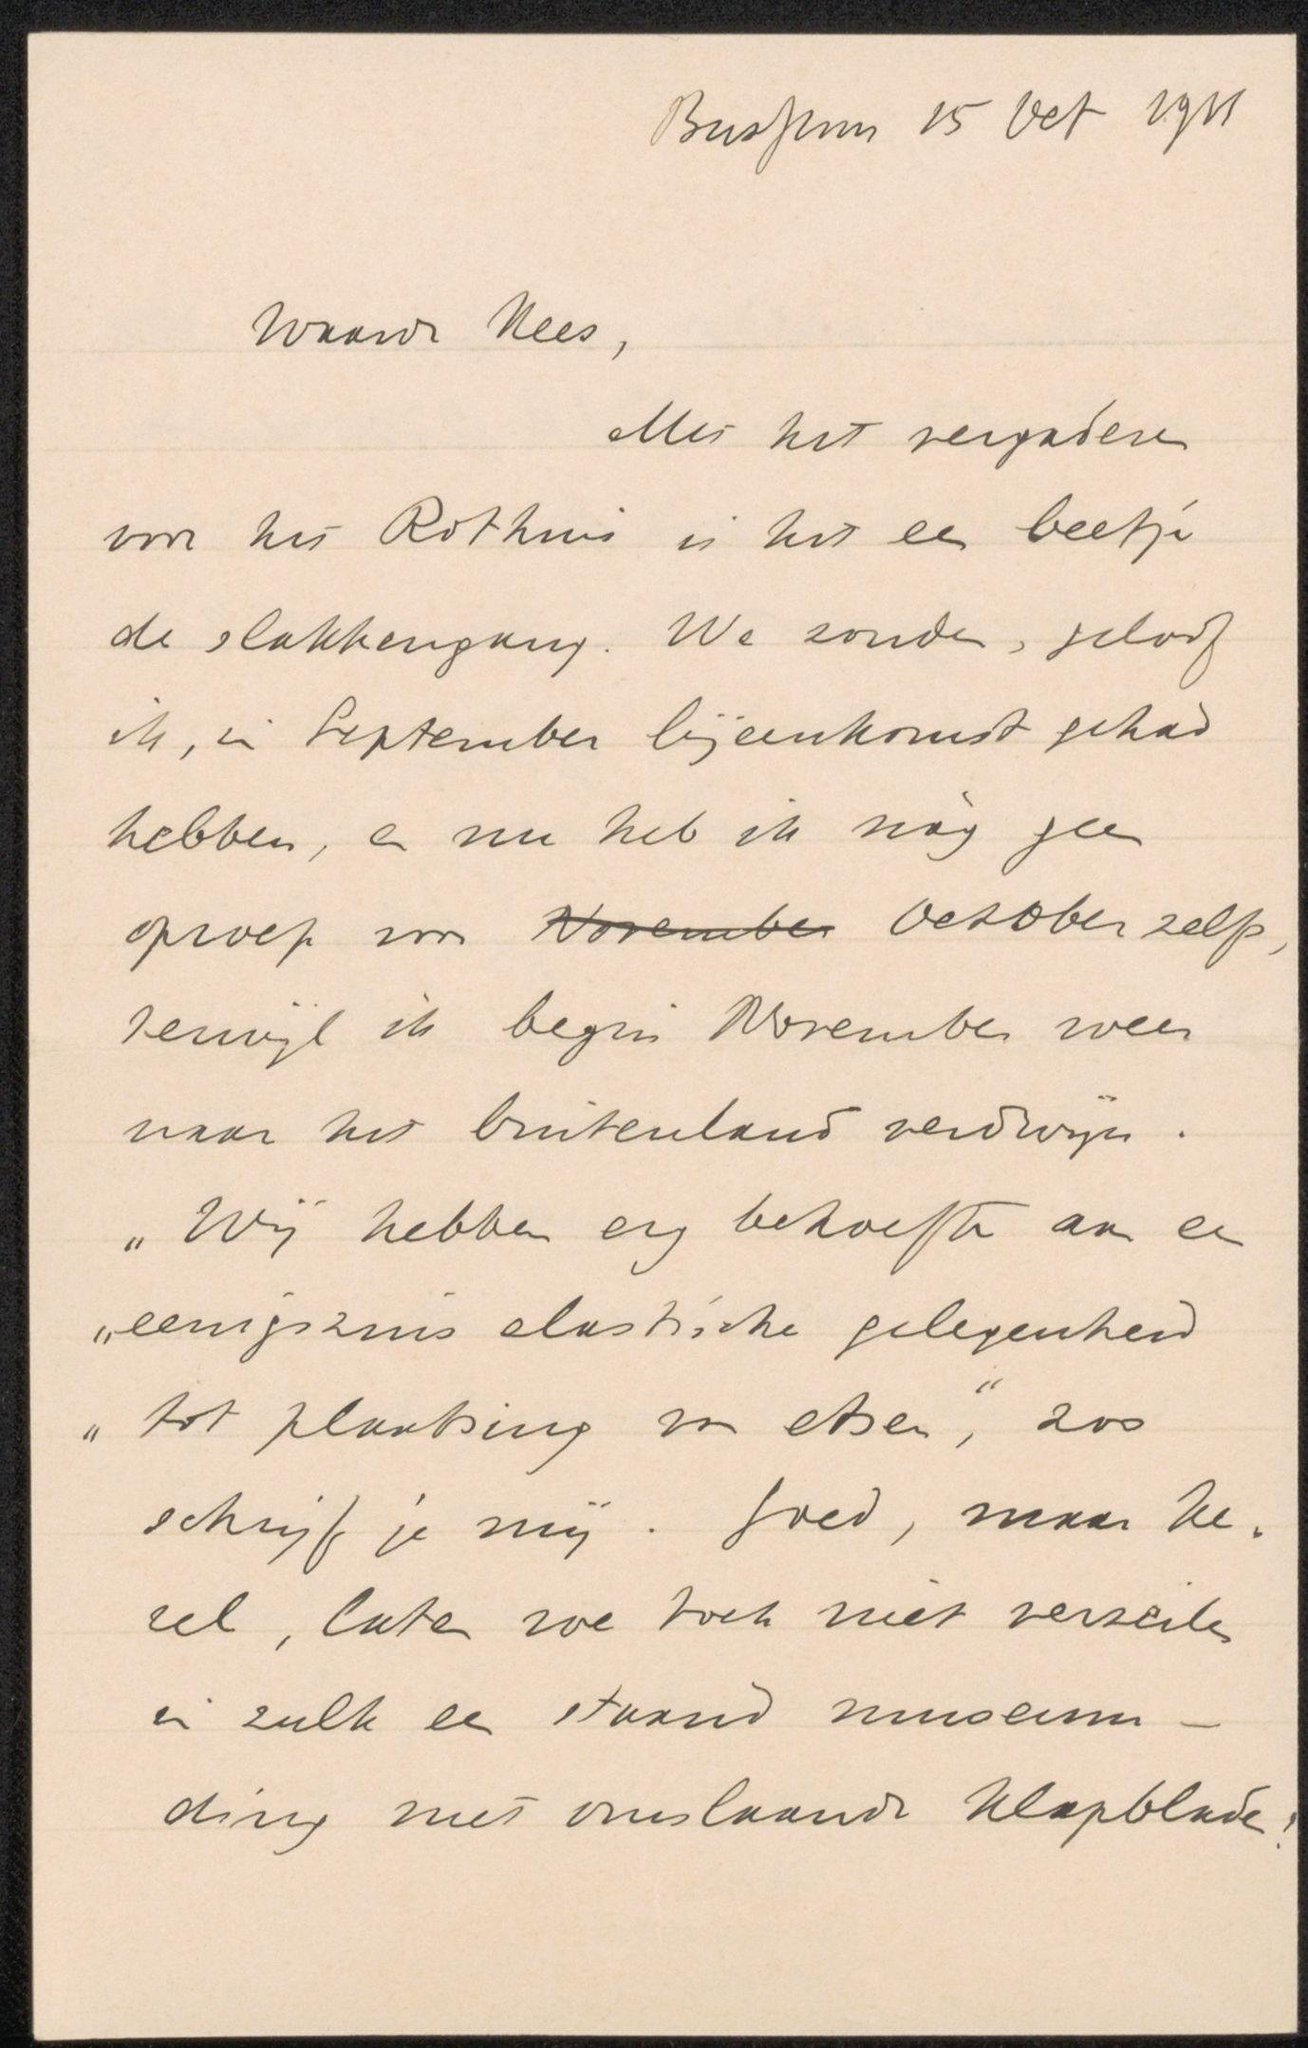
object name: letter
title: Brief aan Cornelis Gerdus 't Hooft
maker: jan veth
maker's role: designer, draughtsman, painter, print maker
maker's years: 1864-1925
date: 1911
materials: ink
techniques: pen, writing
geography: bussum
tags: abraham bredius, dordrecht, painter, draughtsman, cornelis gerardus 't hooft, the graphic arts, exhibition ~ art, london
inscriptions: collector's mark: ‘RPK’